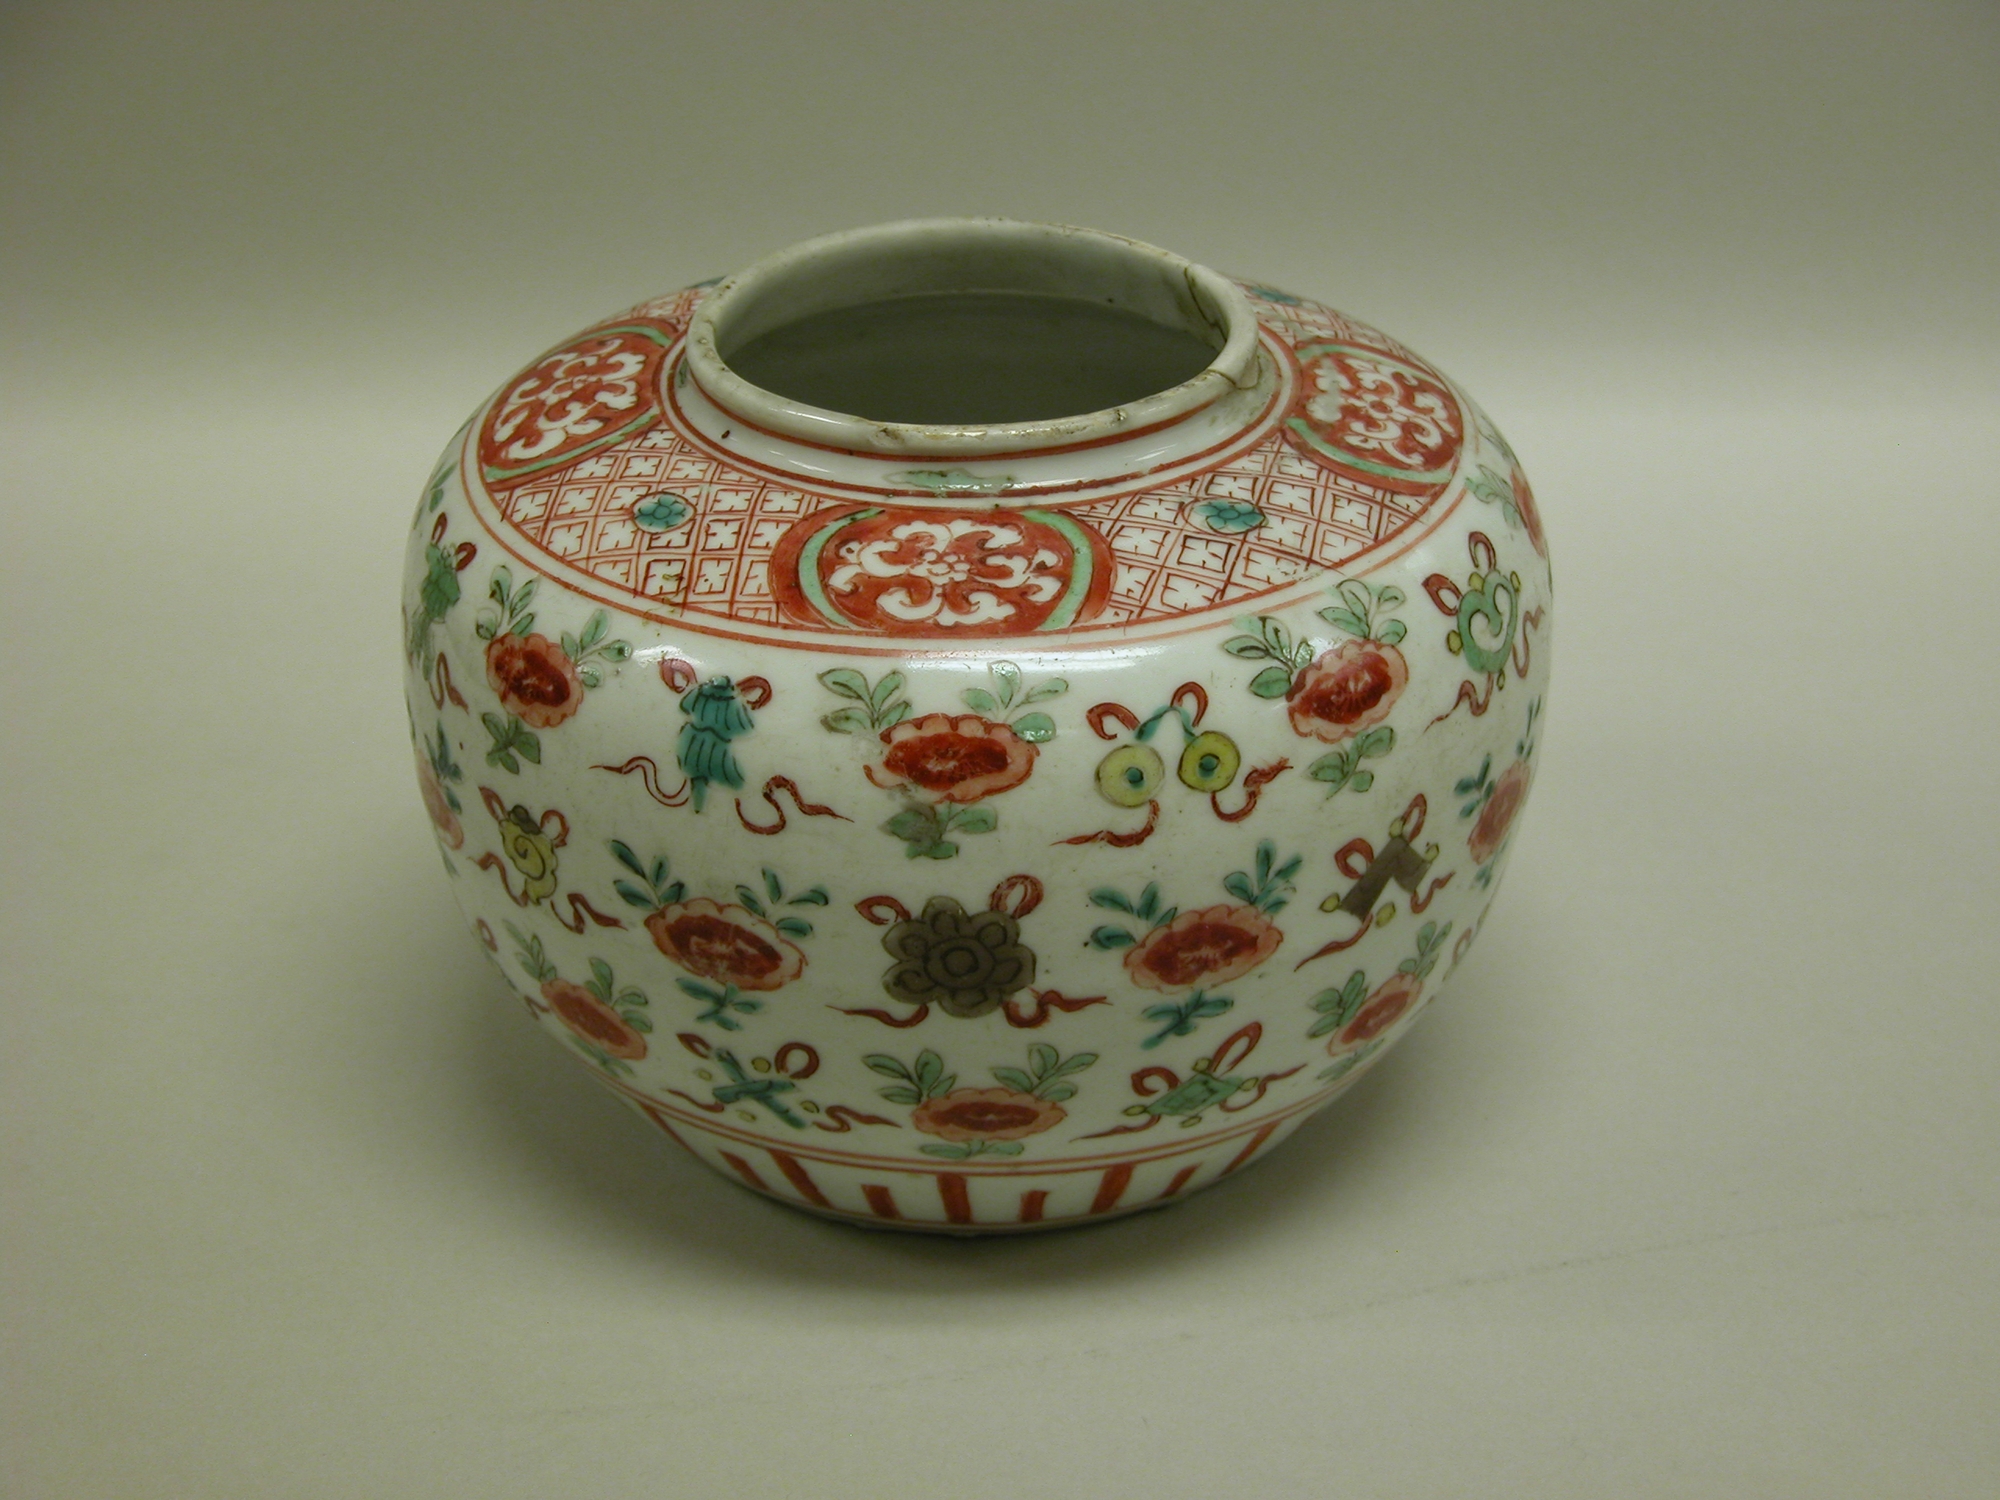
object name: bowl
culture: chinese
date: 1001-1200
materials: glaze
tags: flowers